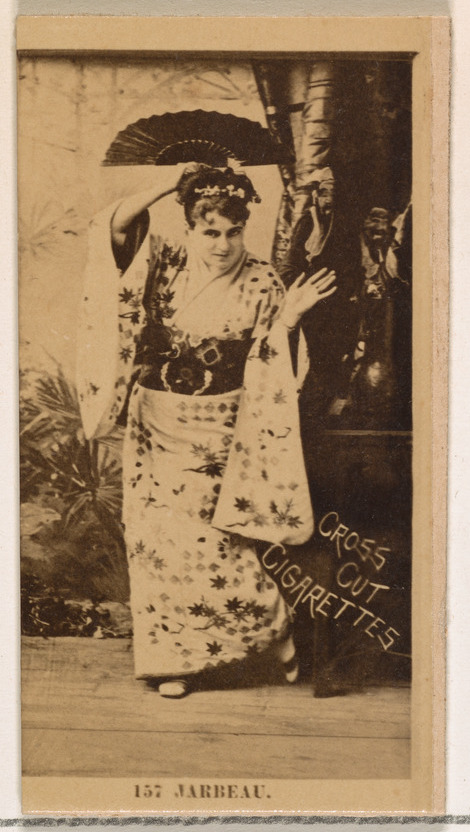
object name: print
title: Card Number 157, Miss Jarbeau, from the Actors and Actresses series (N145-2) issued by Duke Sons & Co. to promote Cross Cut Cigarettes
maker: w. duke, sons & co.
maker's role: publisher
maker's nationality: american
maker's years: 1870-1920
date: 1880-1889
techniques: albumen silver print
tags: portraits,women,actresses